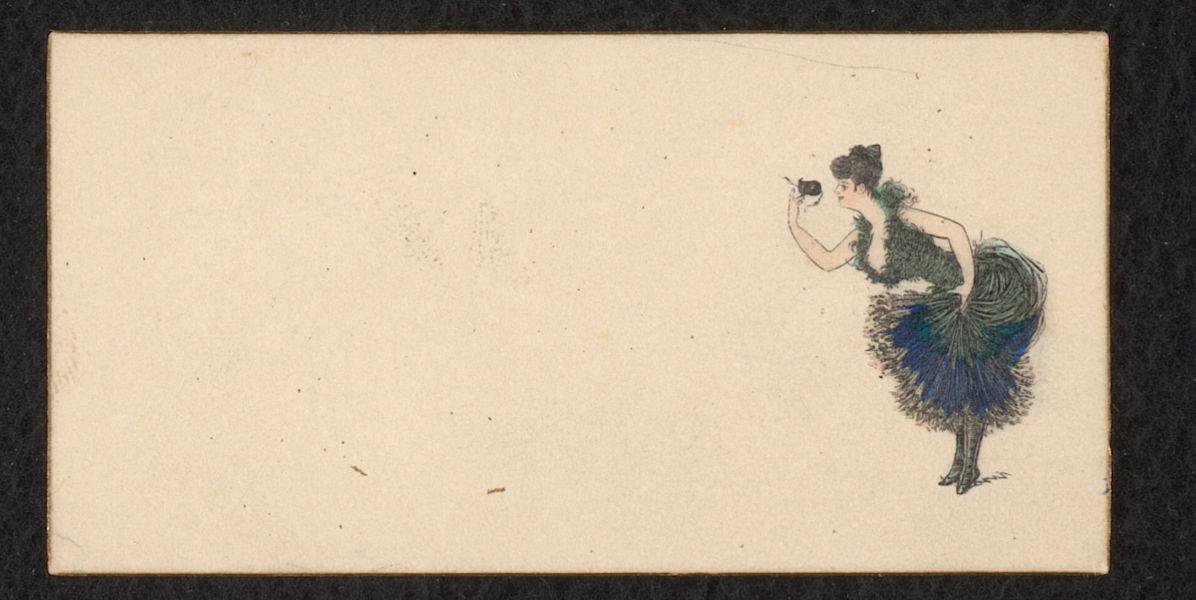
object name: photomechanical print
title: Vrouw in baljurk ruikt aan een bloem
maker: Anonymous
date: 1870-1920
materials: paint, paper, watercolor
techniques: hand coloring, printing block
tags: party clothes, festive attire, dress, gown: ball gown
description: Mogelijk een (oningevulde) plaatskaart voor een diner. Bij gebrek aan gegevens over de vervaardiger is voor de bepaling van de rechten van dit object gebruik gemaakt van de vervaardigingsdatum.